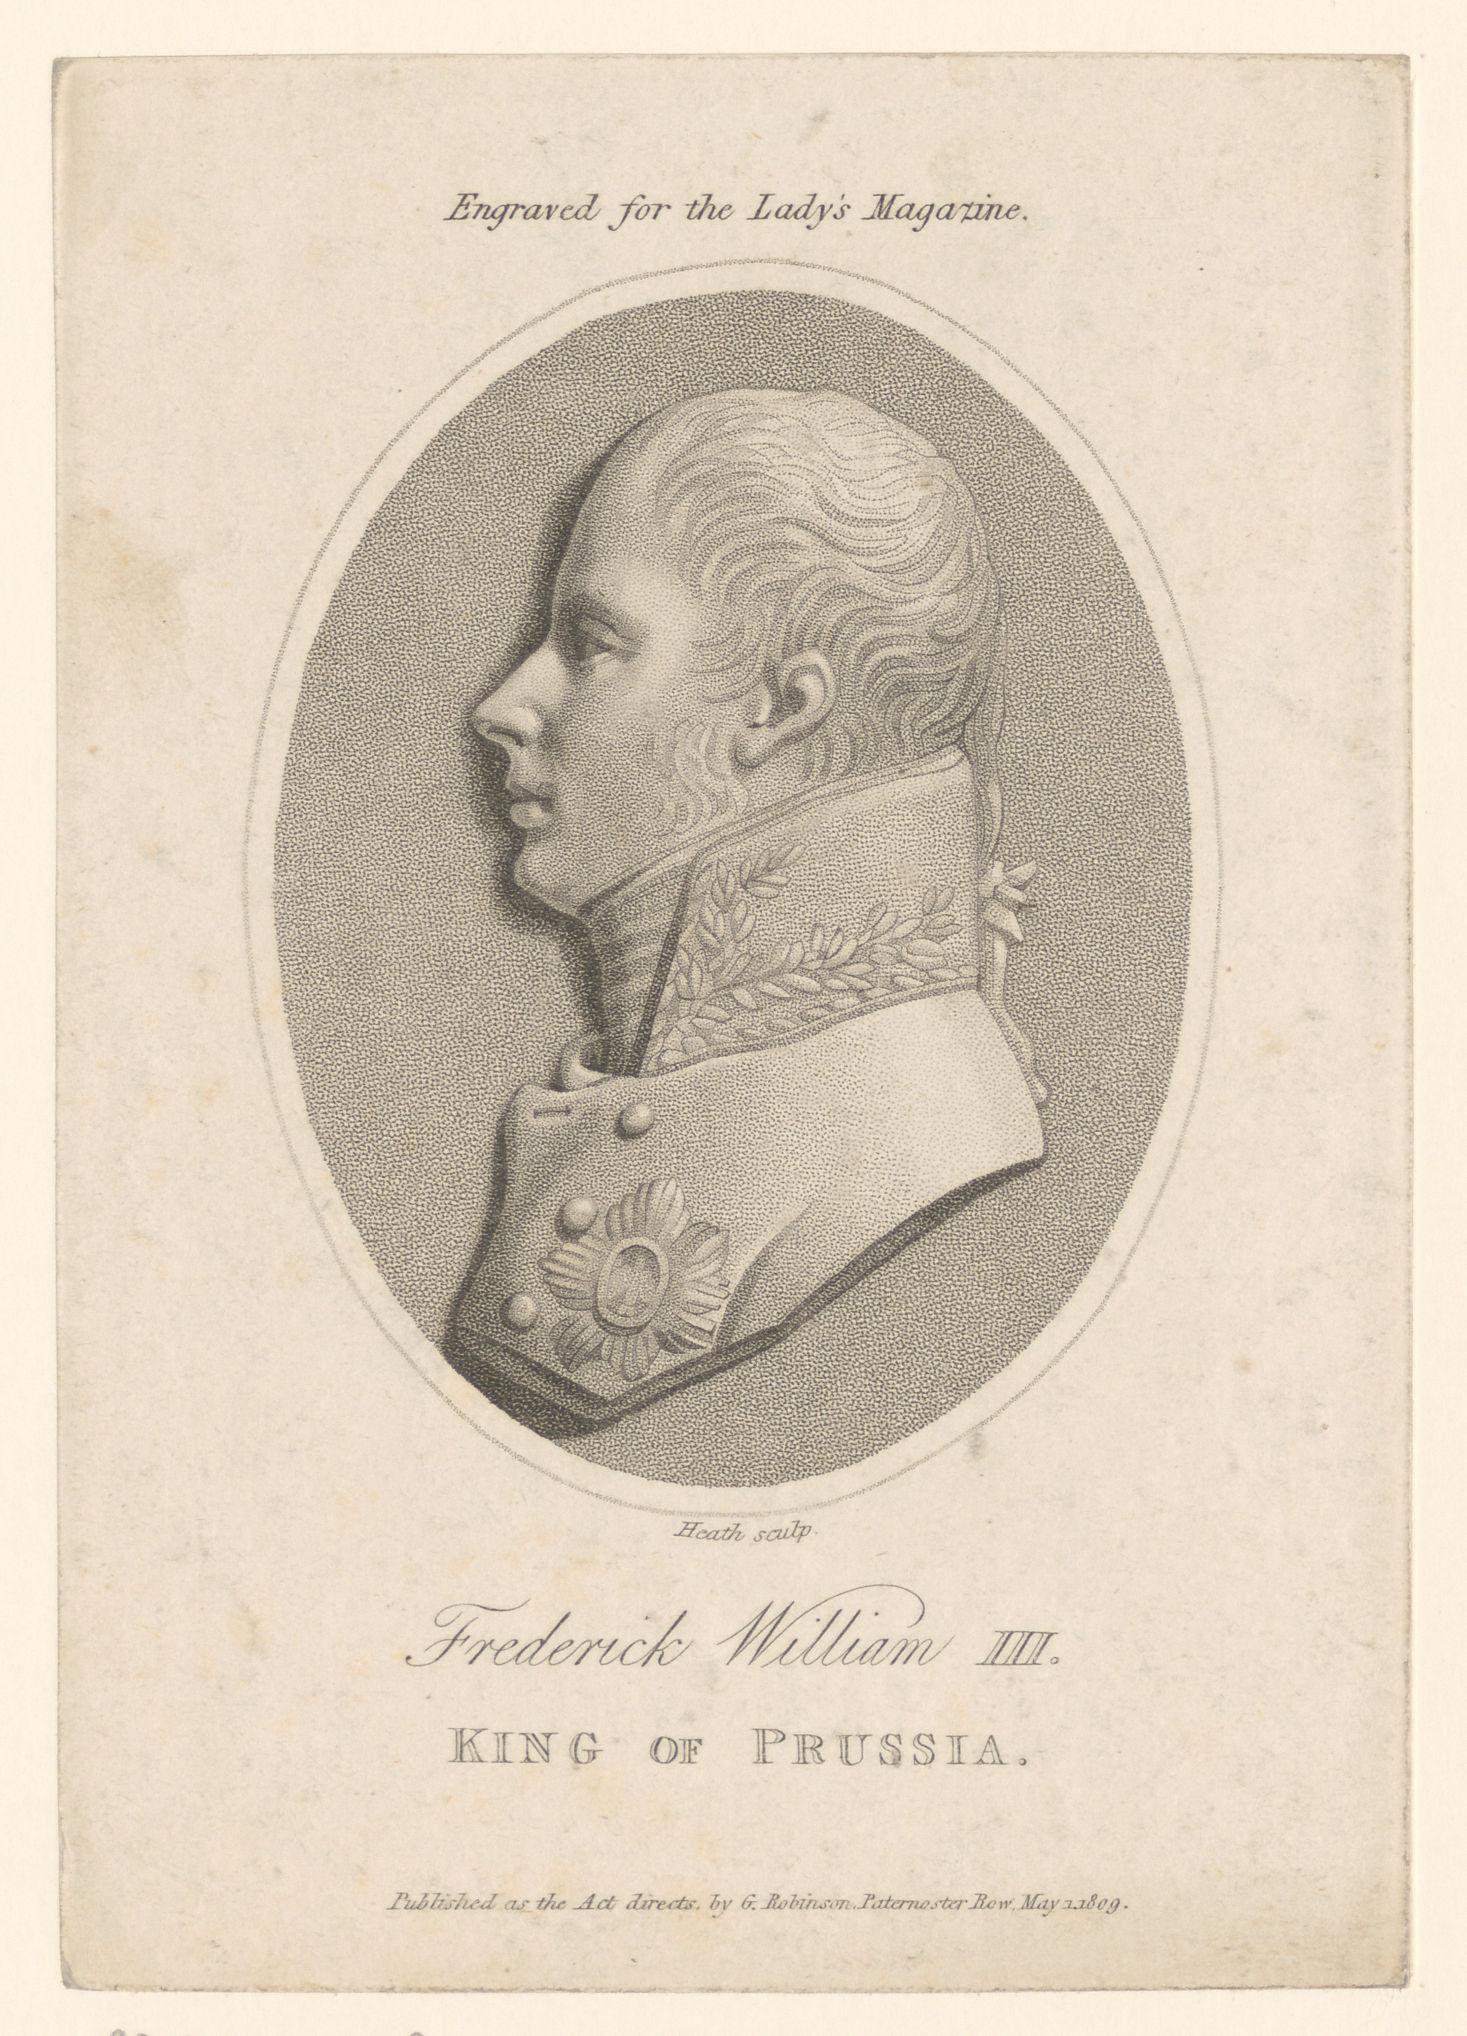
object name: print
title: Frederick William III King of Prussia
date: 1805-1809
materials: paper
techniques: stippling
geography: london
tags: berlin, frederik willem iii koning van pruisen, historical persons, king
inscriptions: collector's mark: Lugt 2228